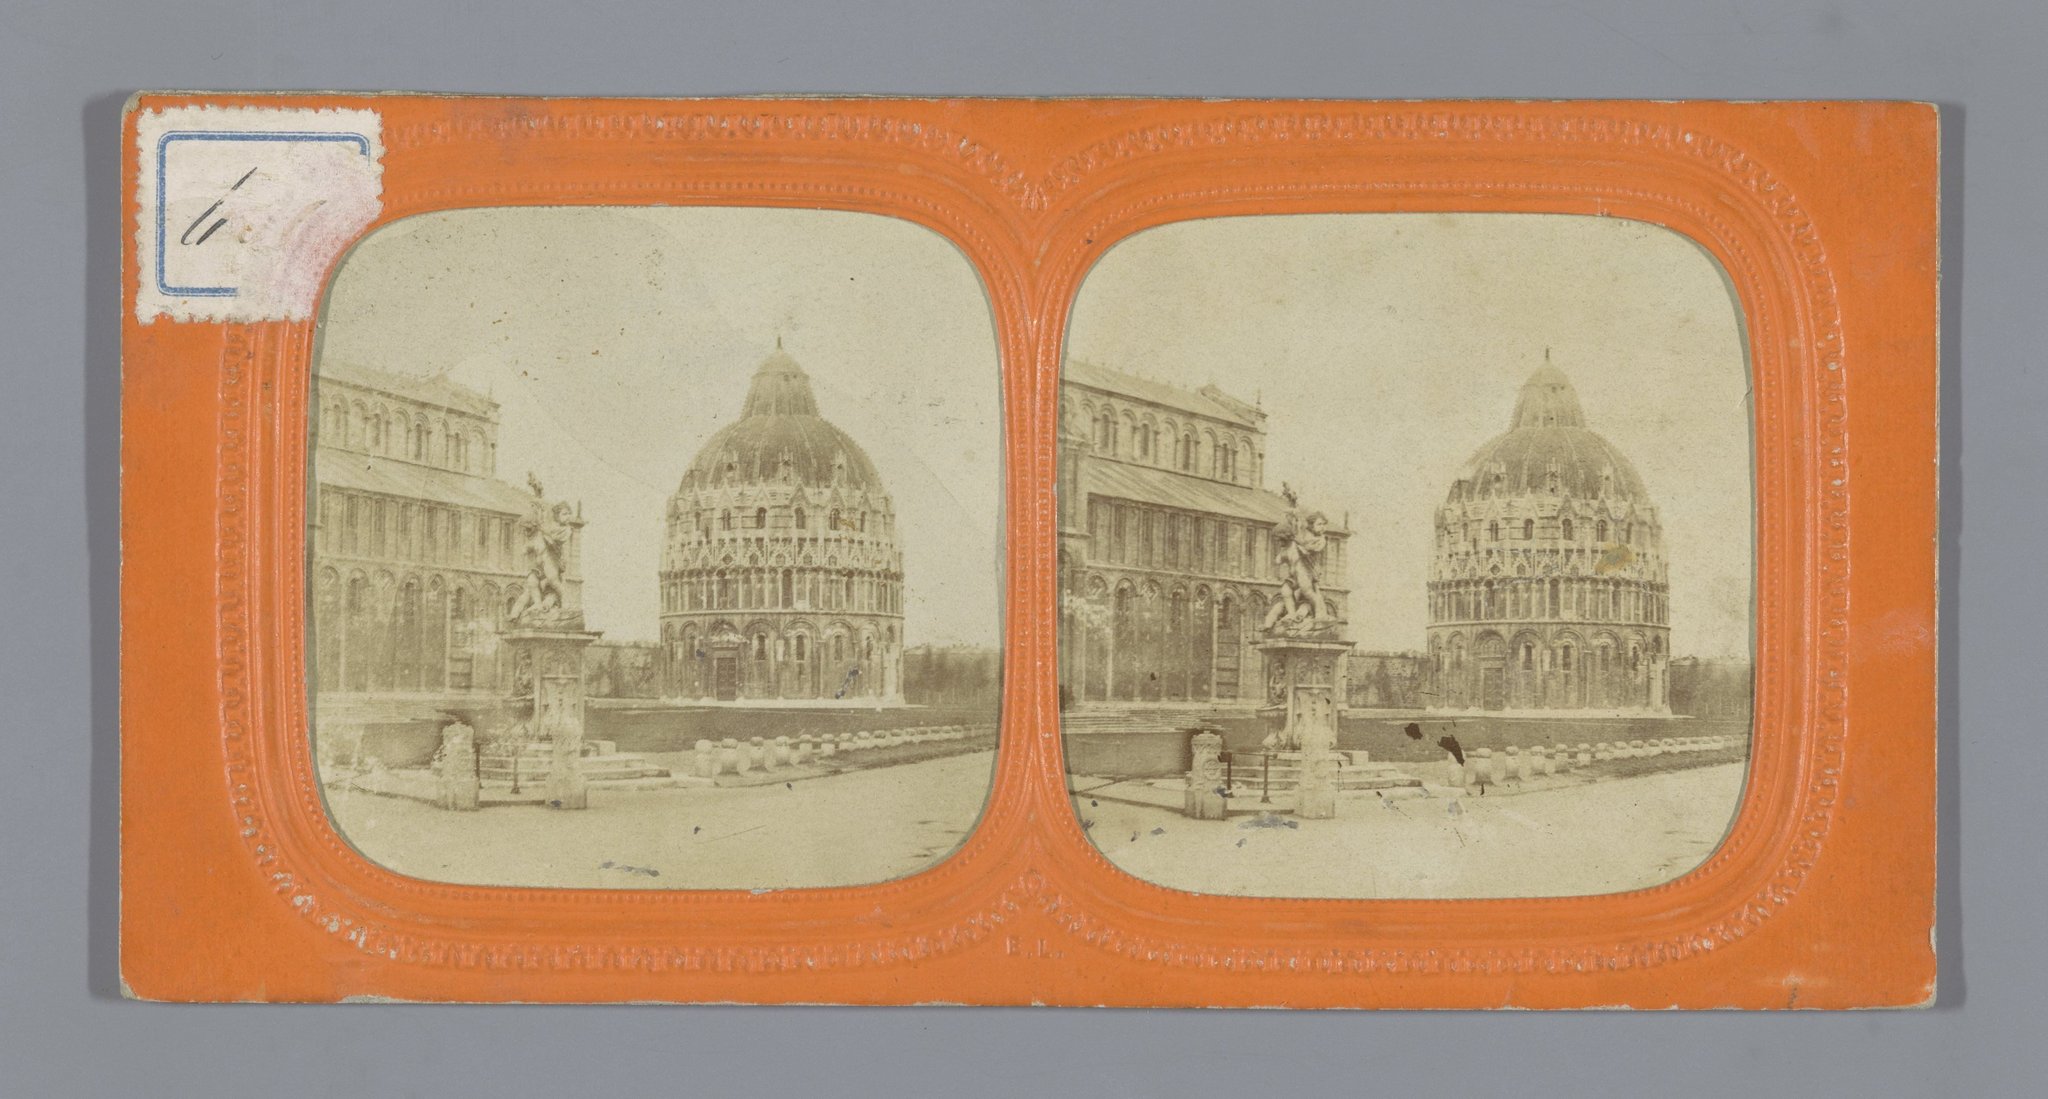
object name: tissue stereograph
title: Baptisterium van Pisa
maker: Anonymous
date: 1855-1875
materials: cardboard, paper, photographic support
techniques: albumen print, hand coloring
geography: pisa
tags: parts of church exterior and annexes: chapel - qq - small church, chapel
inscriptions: inscription: ‘[...]’